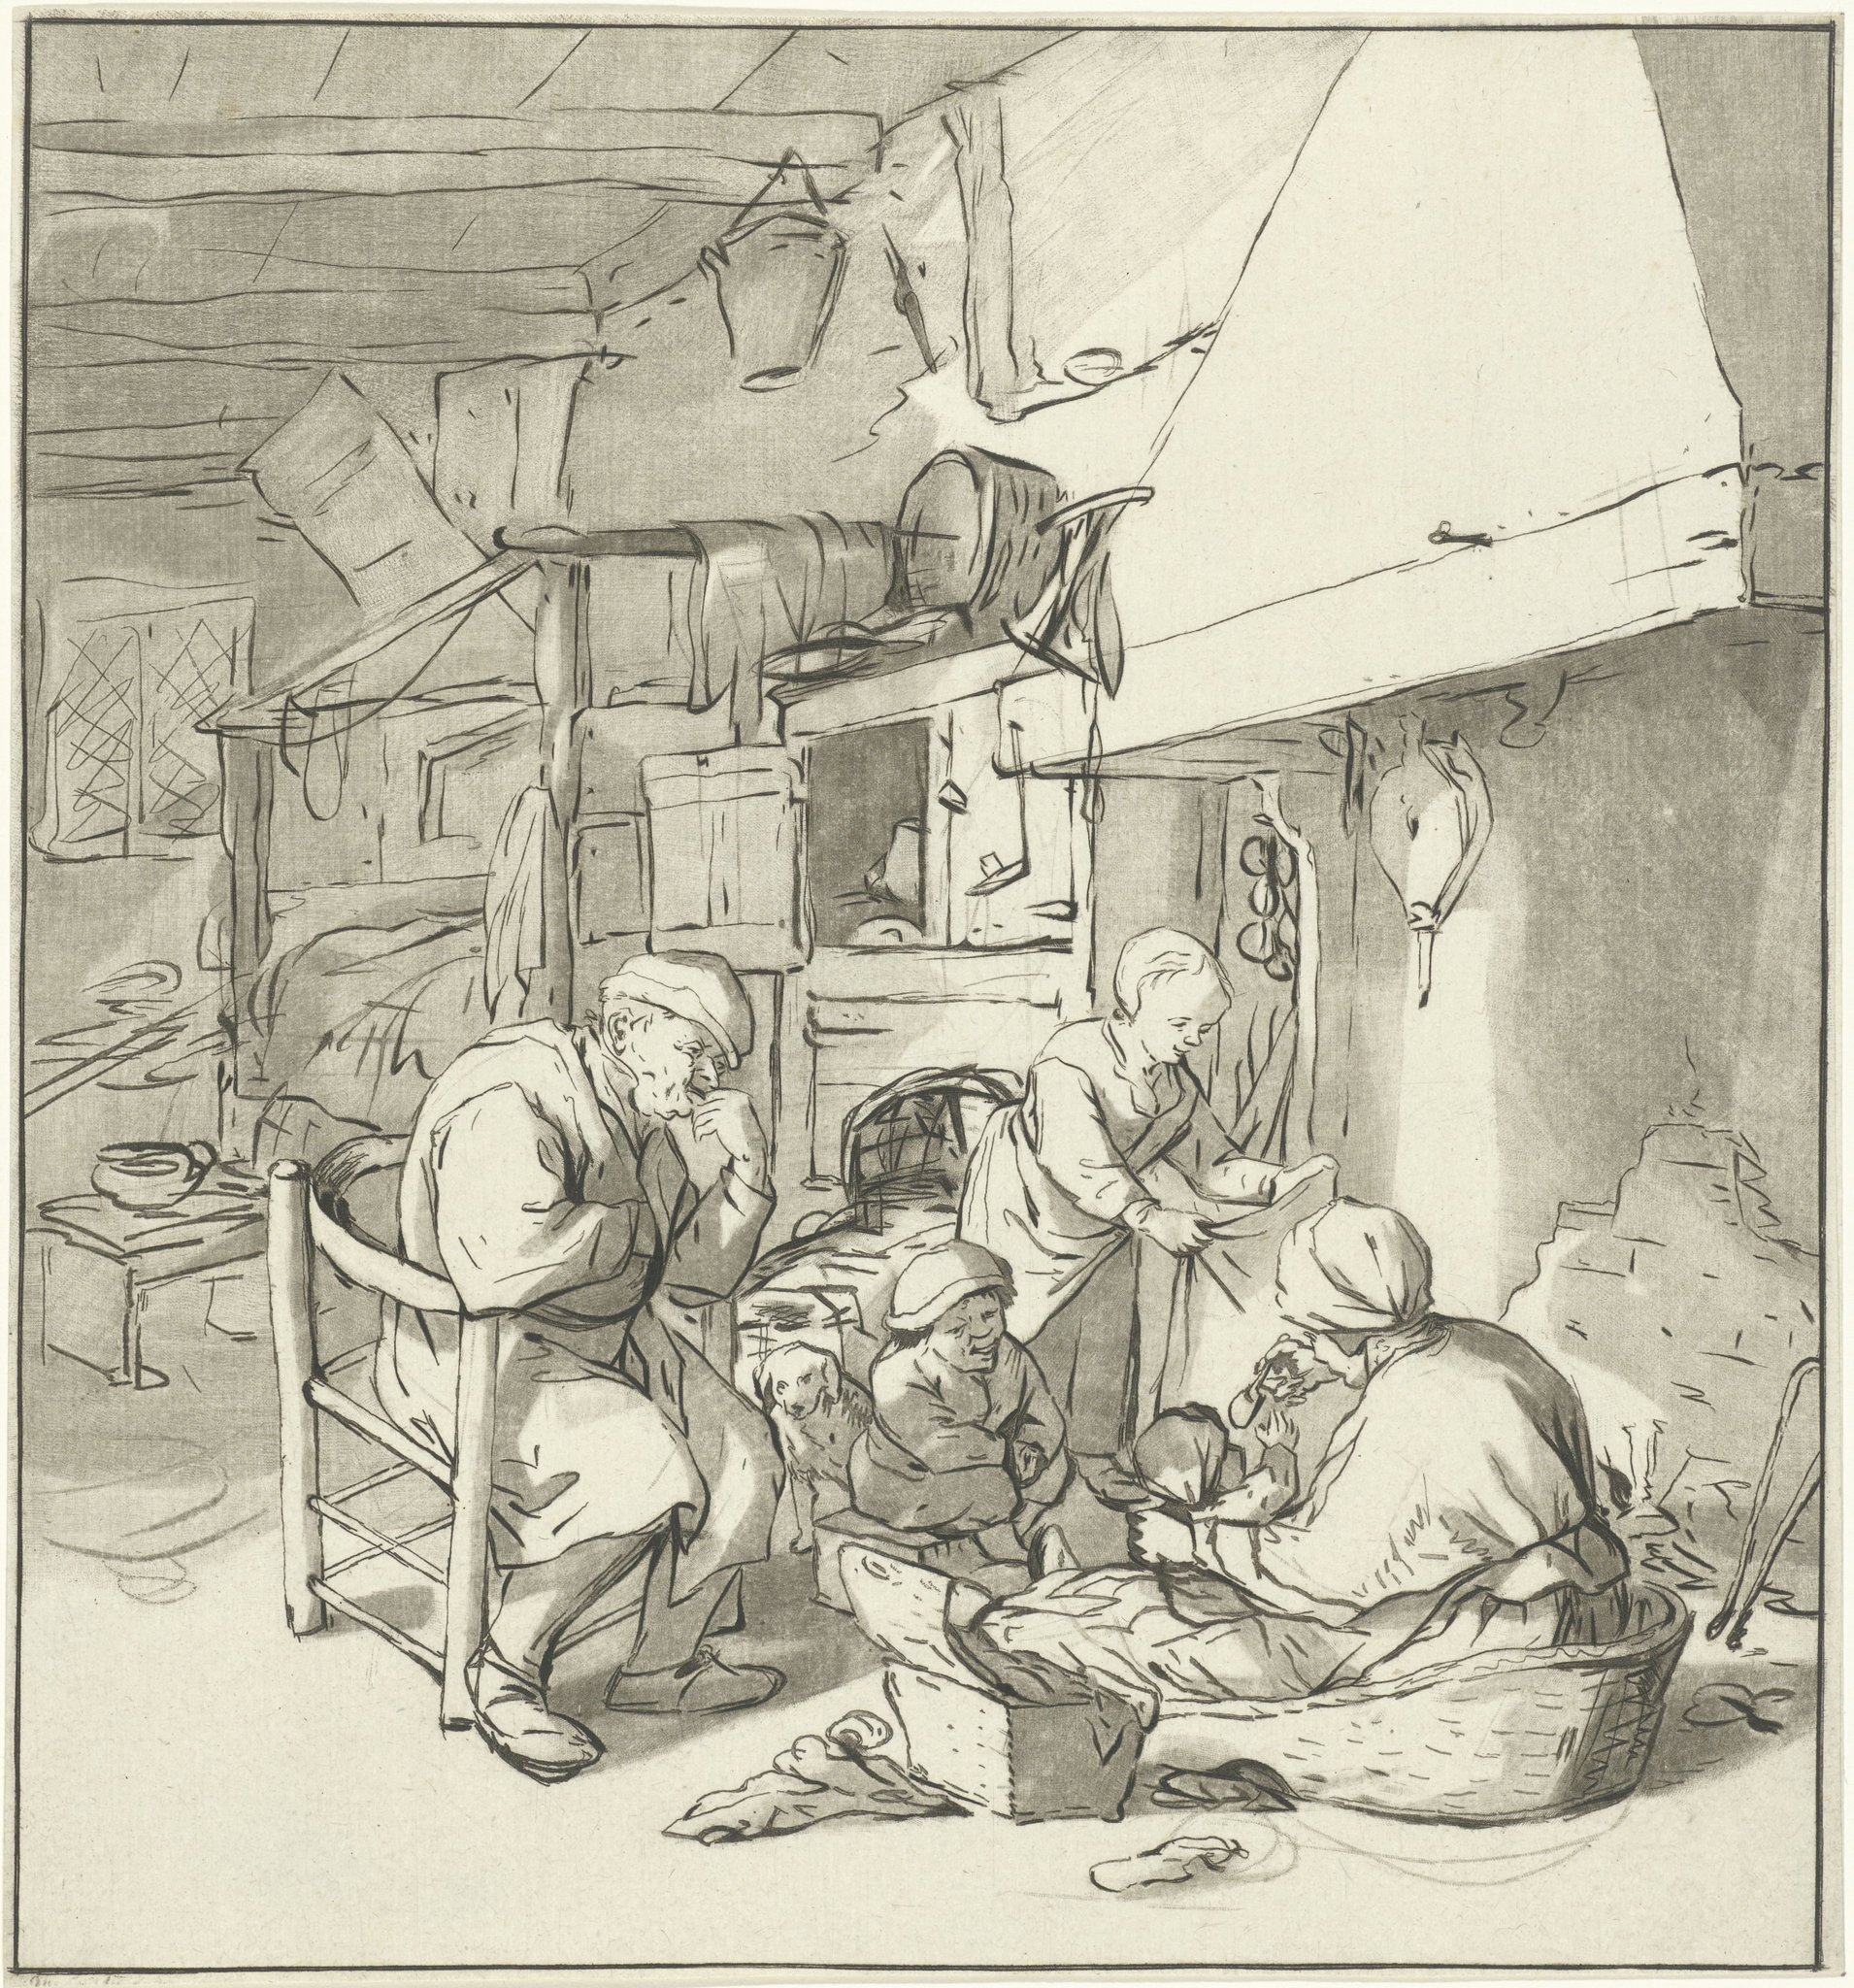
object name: print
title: Boerengezin bij schoorsteen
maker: cornelis ploos van amstel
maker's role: draughtsman, print maker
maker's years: 1726-1798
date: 1767-1821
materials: paper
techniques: etching, roulette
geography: amsterdam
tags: open hearth, fire-place, interior of the house, family life at home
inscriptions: collector's mark: Lugt 240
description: Interieur met een gezin rond de schoorsteen. Een moeder voedt haar baby.